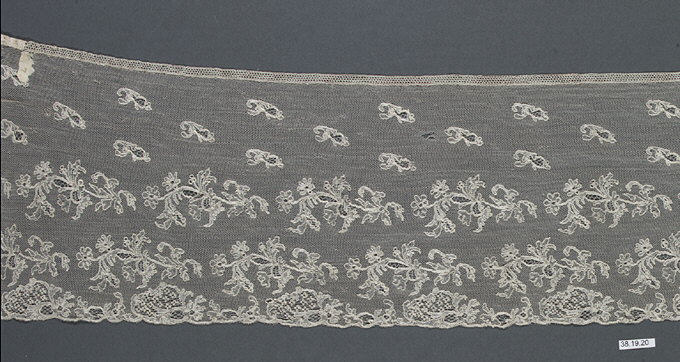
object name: flounce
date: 1701-1800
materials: lace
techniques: lace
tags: flowers